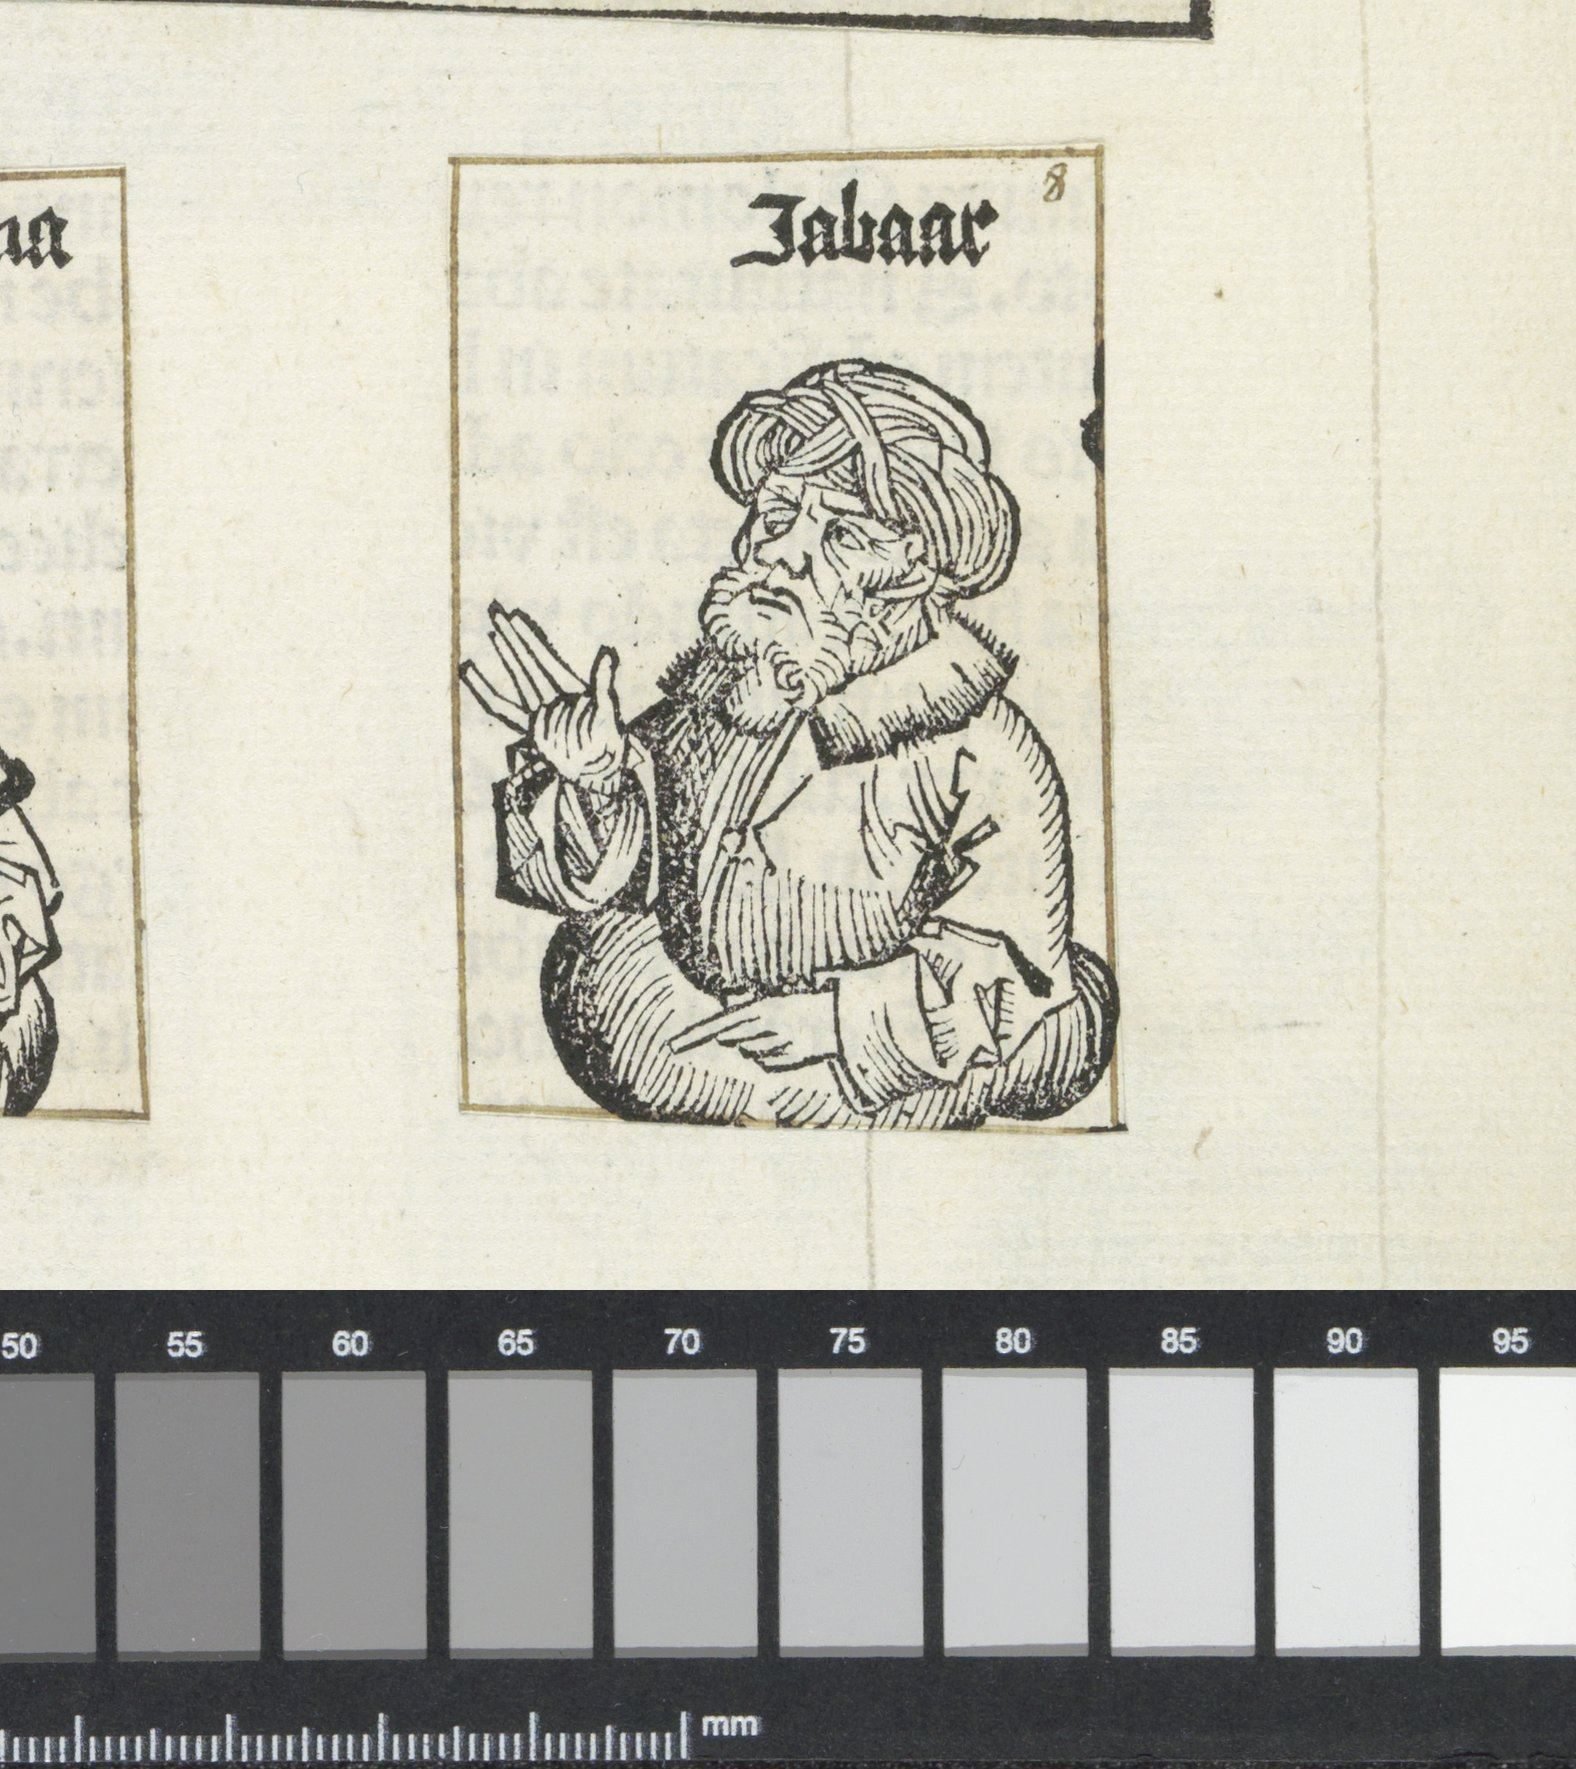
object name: print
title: Jabaar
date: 1493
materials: paper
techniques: letterpress printing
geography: nuremberg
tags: persons from the old testament (not in biblical context, nor occurring in legendary/historical extensions included in division 71)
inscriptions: inscription: ‘8’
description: Man met baard en tulband, naar links gedraaid. De voorstelling is een fragment van de stamboom van Christus in de Liber Chronicarum. De tekst identificeert hem als Jibchar, een zoon van koning David geboren te Jeruzalem (2 Sam. 5: 14-16). De prent maakt deel uit van een album.